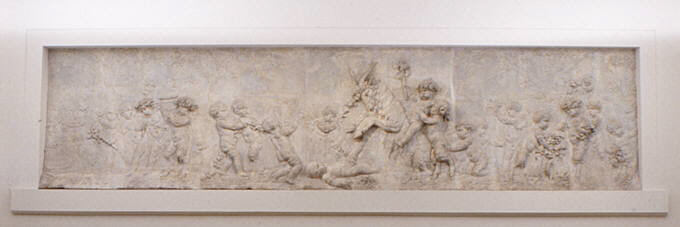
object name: frieze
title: Children and satyr children leading a goat to sacrifice (part of a group)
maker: clodion (claude michel)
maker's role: artist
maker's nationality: french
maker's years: 1738-1814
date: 1781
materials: plaster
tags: boys,satyrs,goats